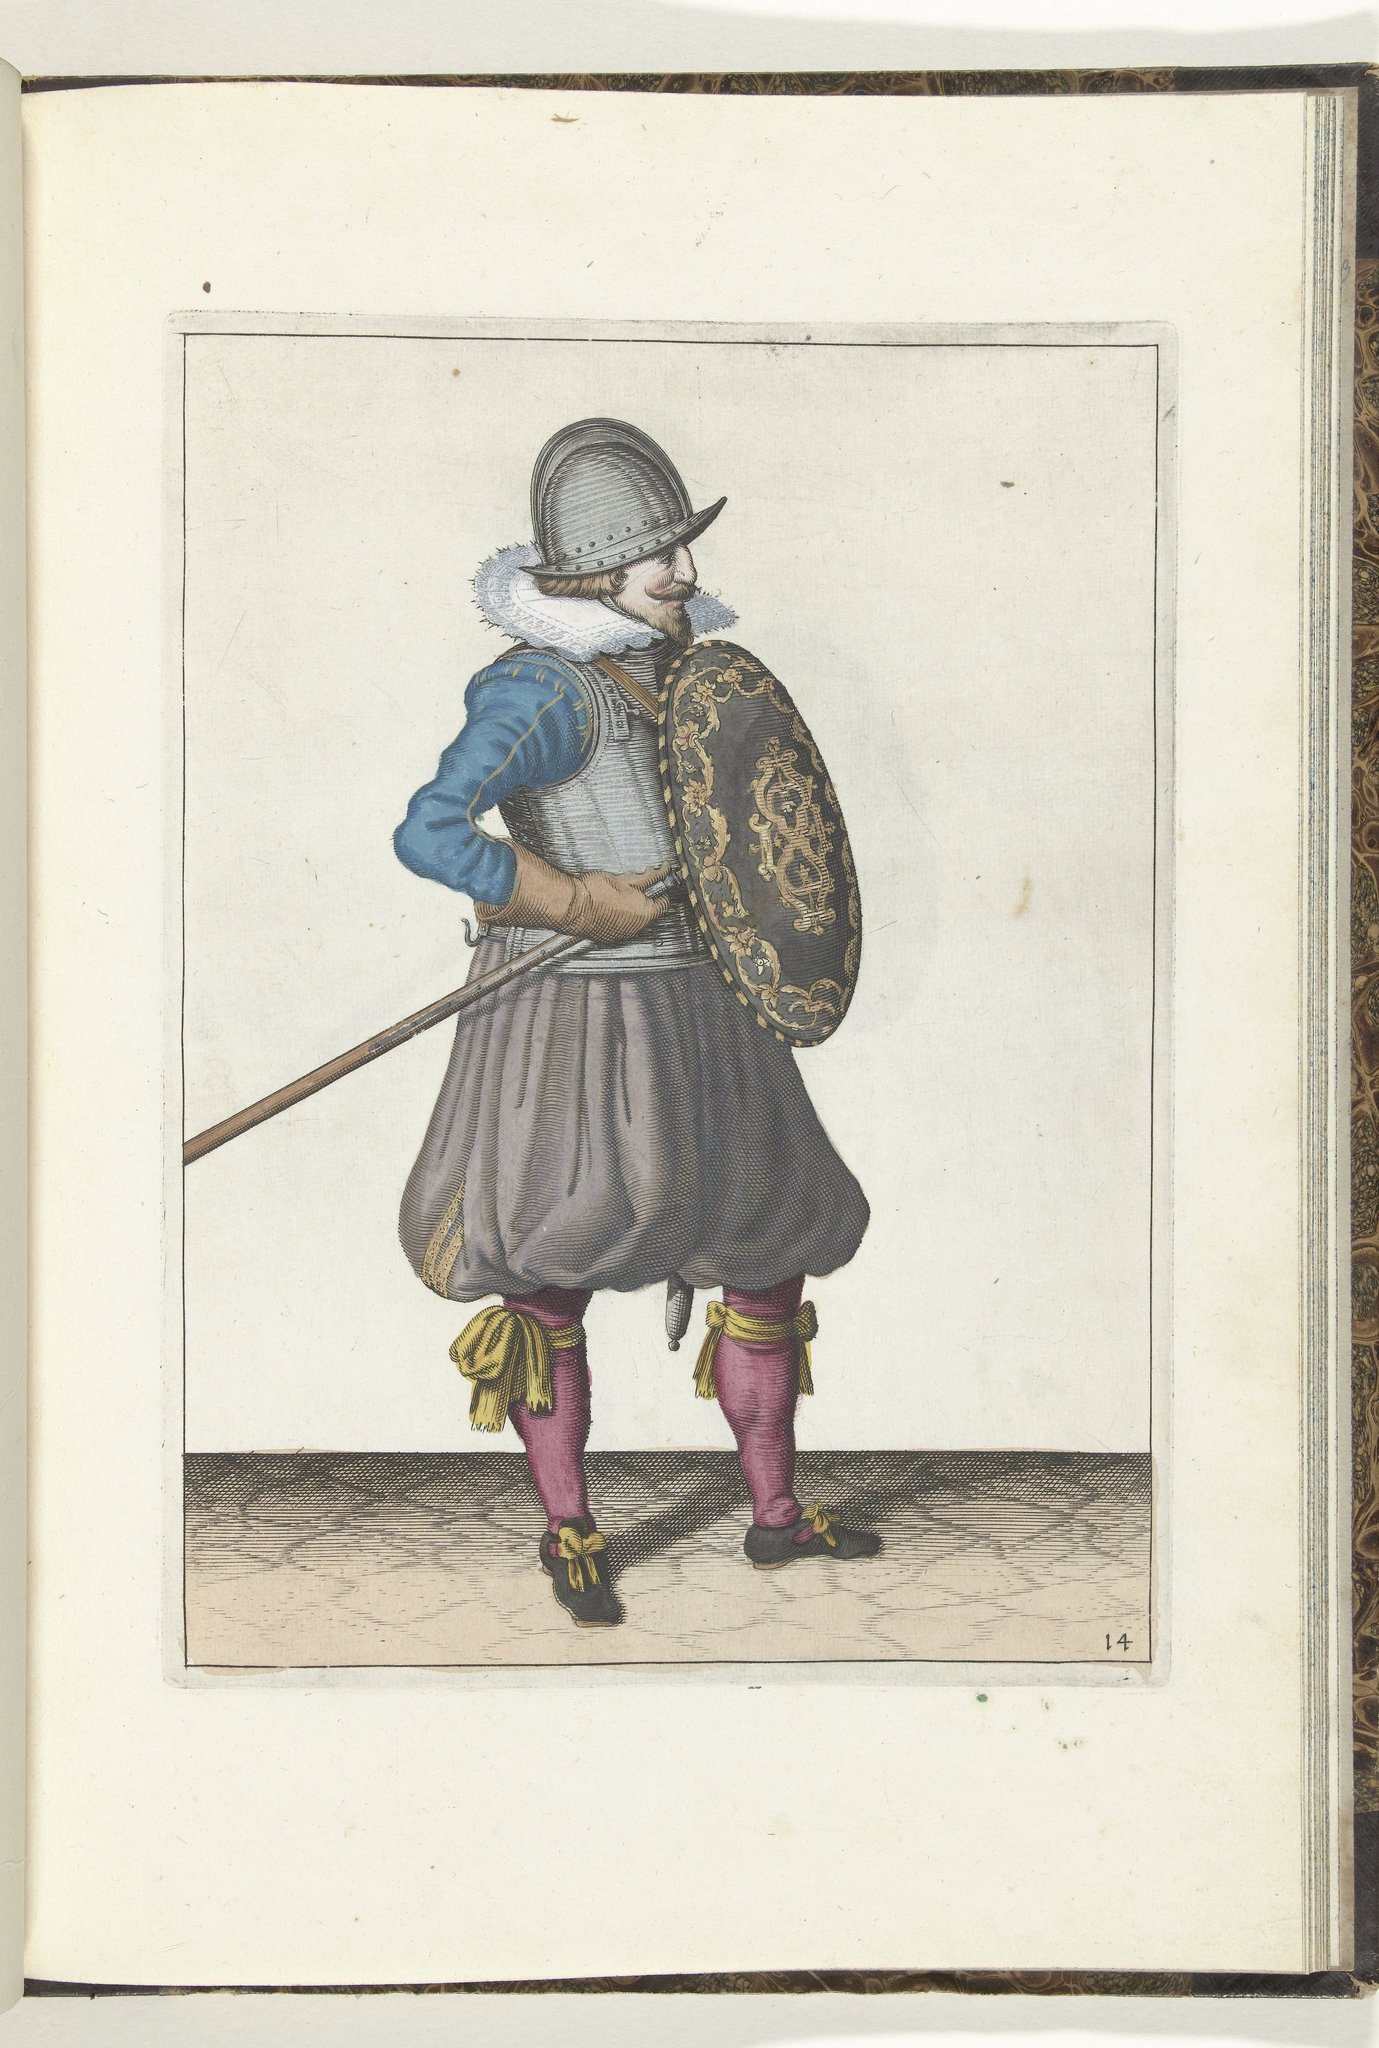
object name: print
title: De exercitie met schild en spies: de soldaat brengt in twee tijden de spies in positie om te slepen, tweede beweging (nr. 14), 1618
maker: Anonymous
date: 1616-1618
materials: paper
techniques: engraving, hand coloring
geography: northern netherlands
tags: maurice (prince of orange), handling of weapons ~ military training, weapons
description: Illustratie in: Adam van Breen, Nassauische Waffenhandelung [incompleet exemplaar], 1618?, plaat 14. Dit is een Duitse editie van Adam van Breens De Nassausche Wapen-Handelinge, van Schilt, Spies, Rappier ende Targe : beyde figuerlick afgebeelt, ende gestelt na de nieu ordening [van] ... Maurits van Nassau, 's-Gravenhage, [Aert Meuris] 1618. In het exemplaar in de collectie van de Rijksmuseum Research Library (326 F 23).